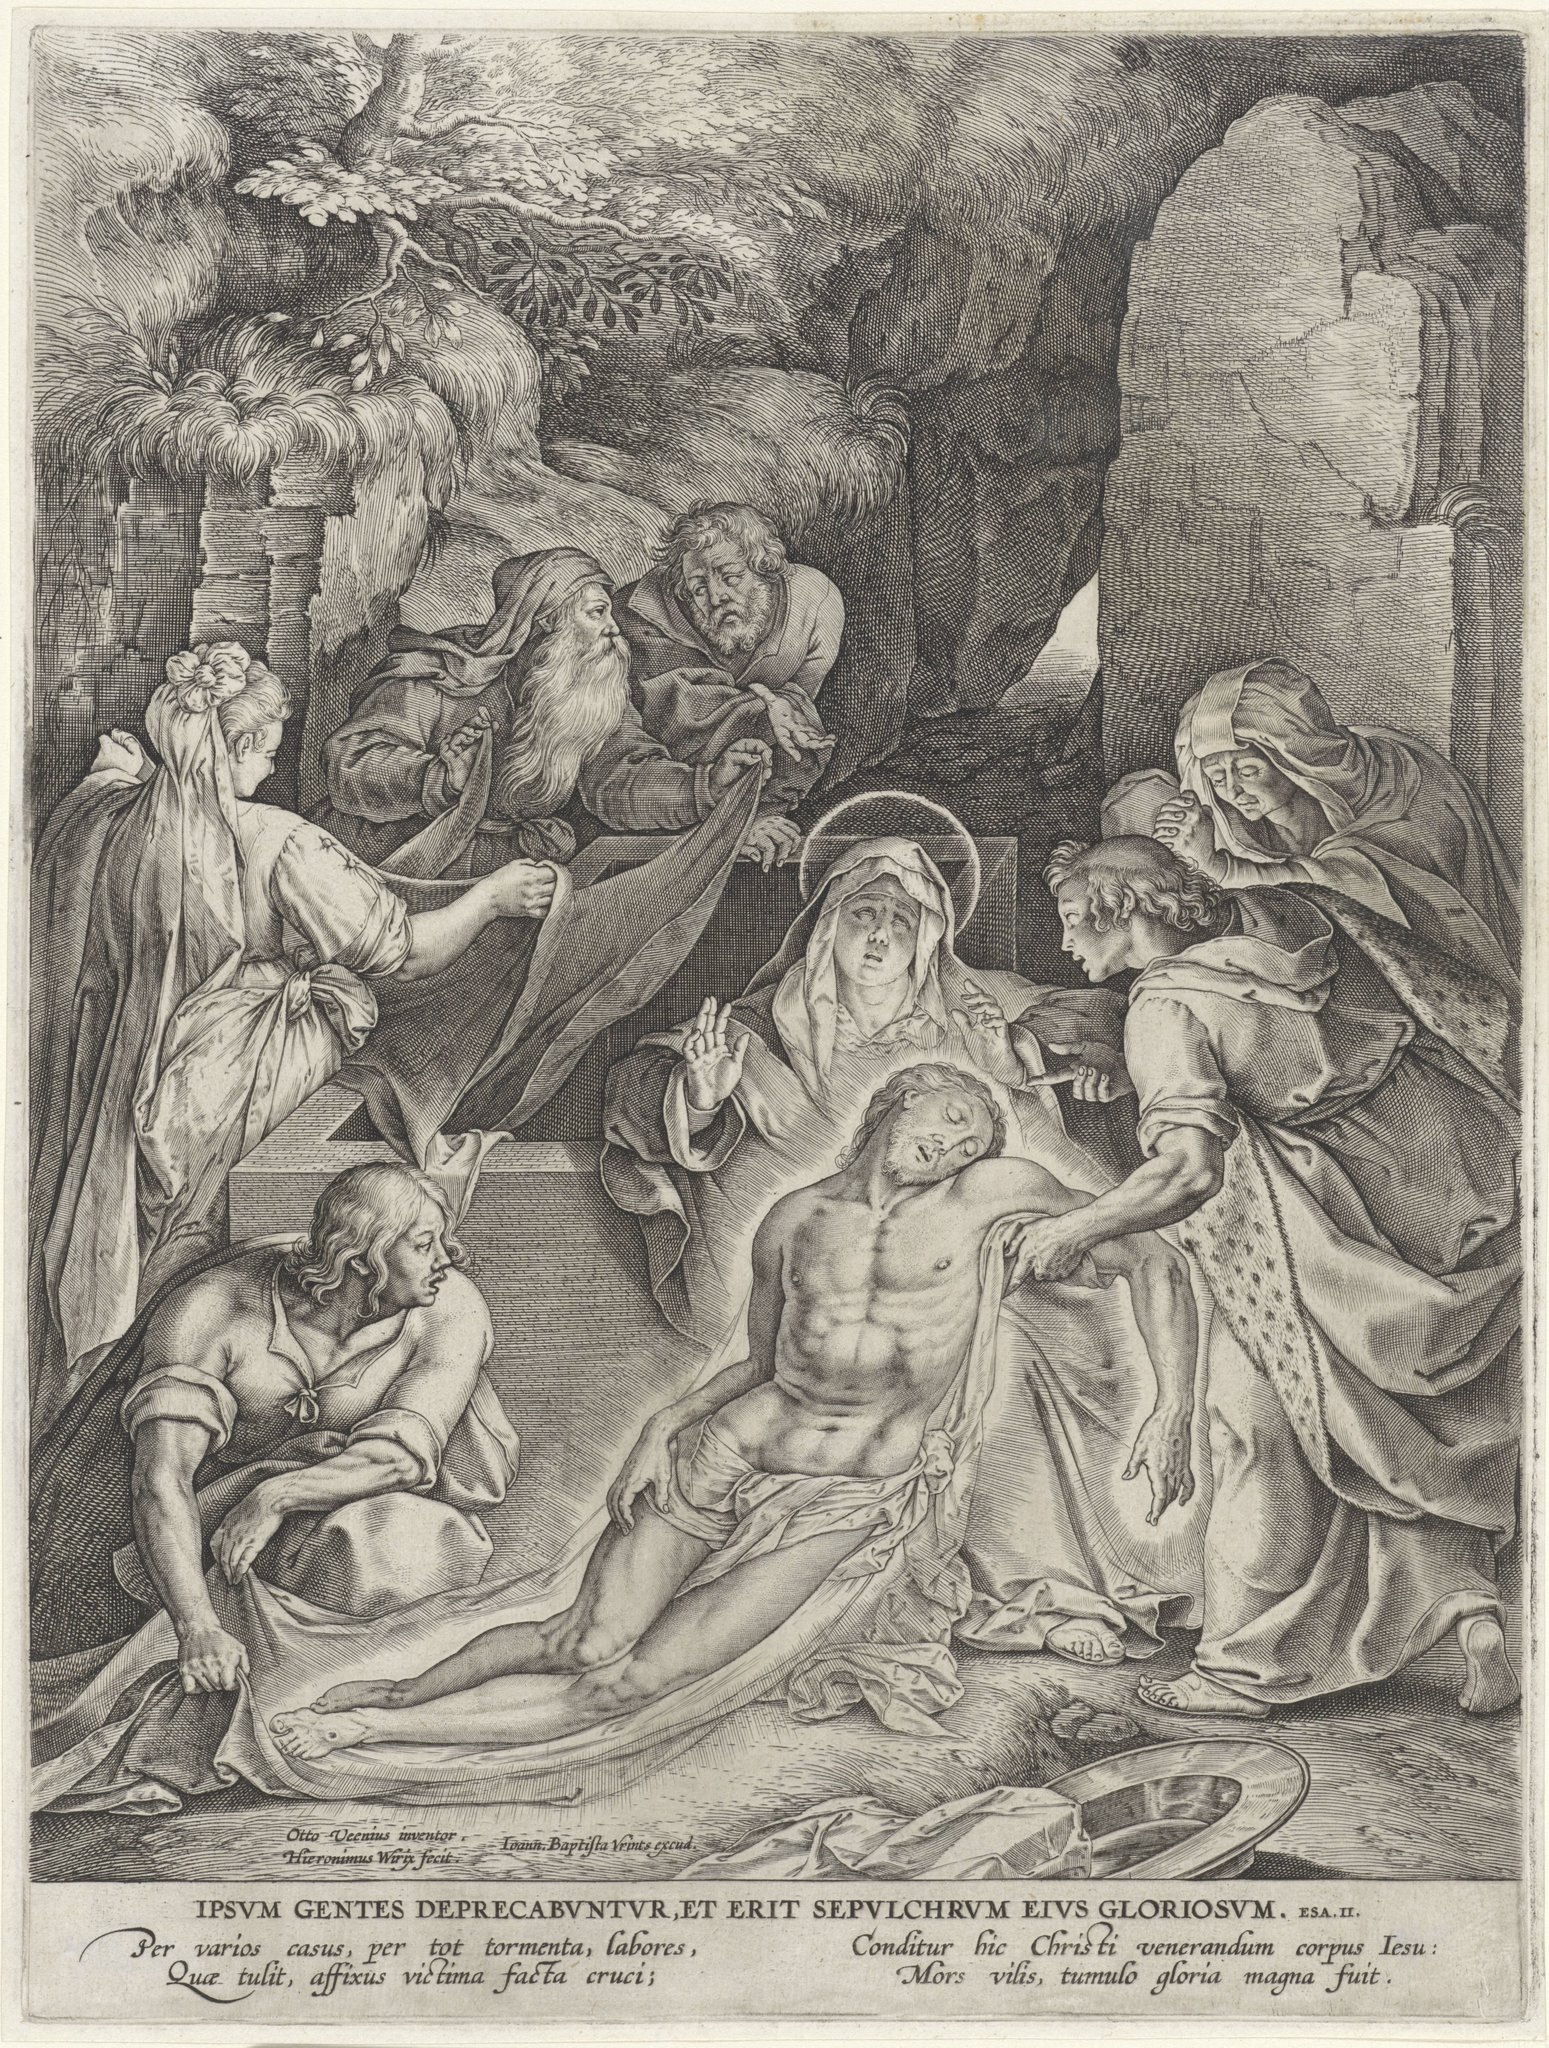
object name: print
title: Graflegging van Christus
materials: paper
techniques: engraving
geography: antwerp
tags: christ's entombment (possibly by angels), 'pietà ', 'vesperbild', 'marienklage' (no others present): christ, either with or without crown of thorns, mourned by mary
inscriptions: collector's mark: Lugt 2228, collector's mark: Lugt 2542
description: Christus wordt door Jozef van Arimatea en Nikodemus in het rotsgraf gelegd. Ze tillen zijn op een lijkwade gelegen lichaam op uit de schoot van Maria. Zij slaat wanhopig haar armen ten hemel. Bij de tombe staan Maria Magdalena en twee mannen. In de marge een Bijbelcitaat uit Jes. 2 in het Latijn.